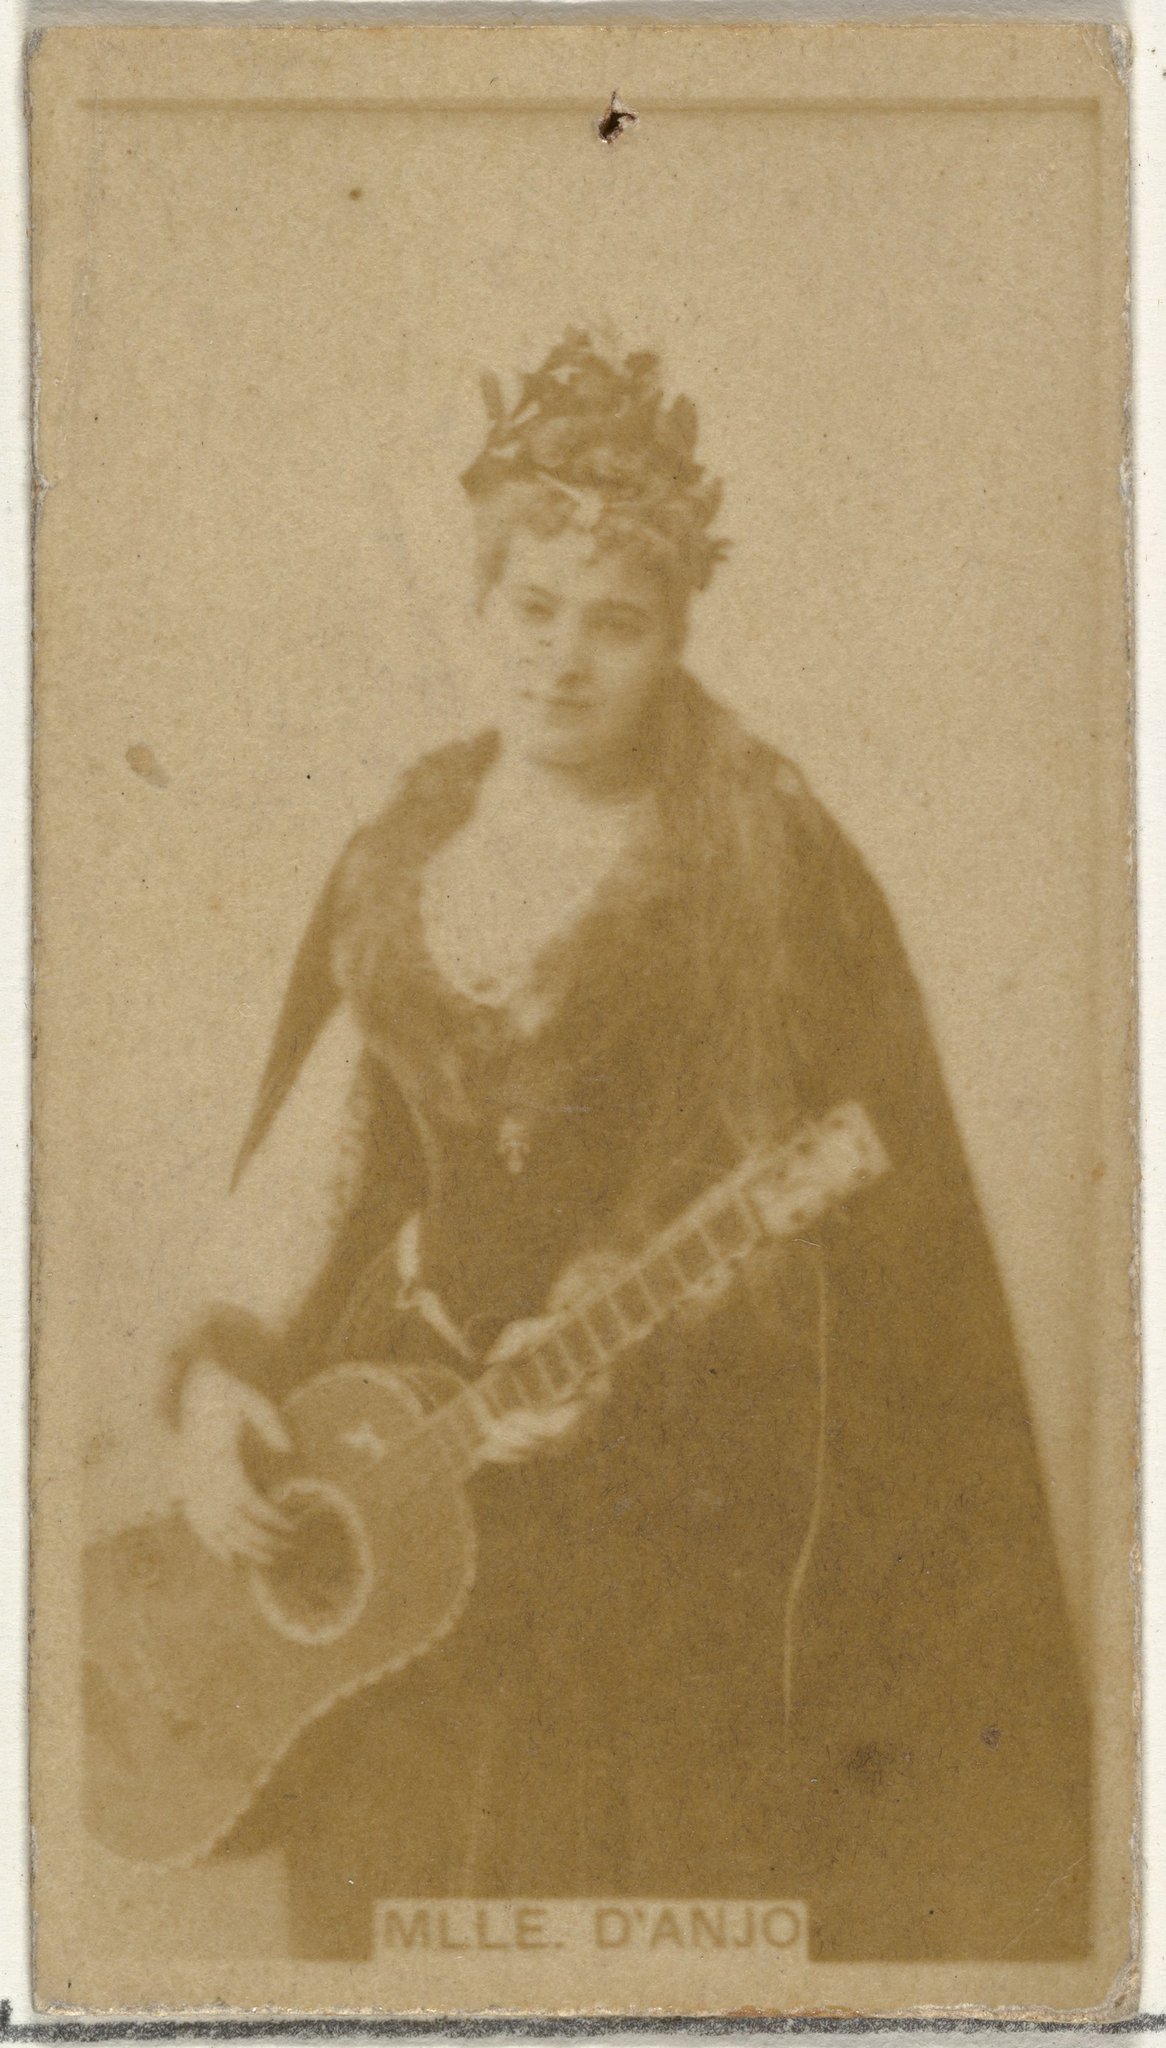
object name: photograph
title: Mlle. D'anjo, from the Actors and Actresses series (N145-8) issued by Duke Sons & Co. to promote Duke Cigarettes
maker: w. duke, sons & co.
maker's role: publisher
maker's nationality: american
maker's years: 1870-1920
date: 1891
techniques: albumen silver print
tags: portraits,women,guitars,actresses